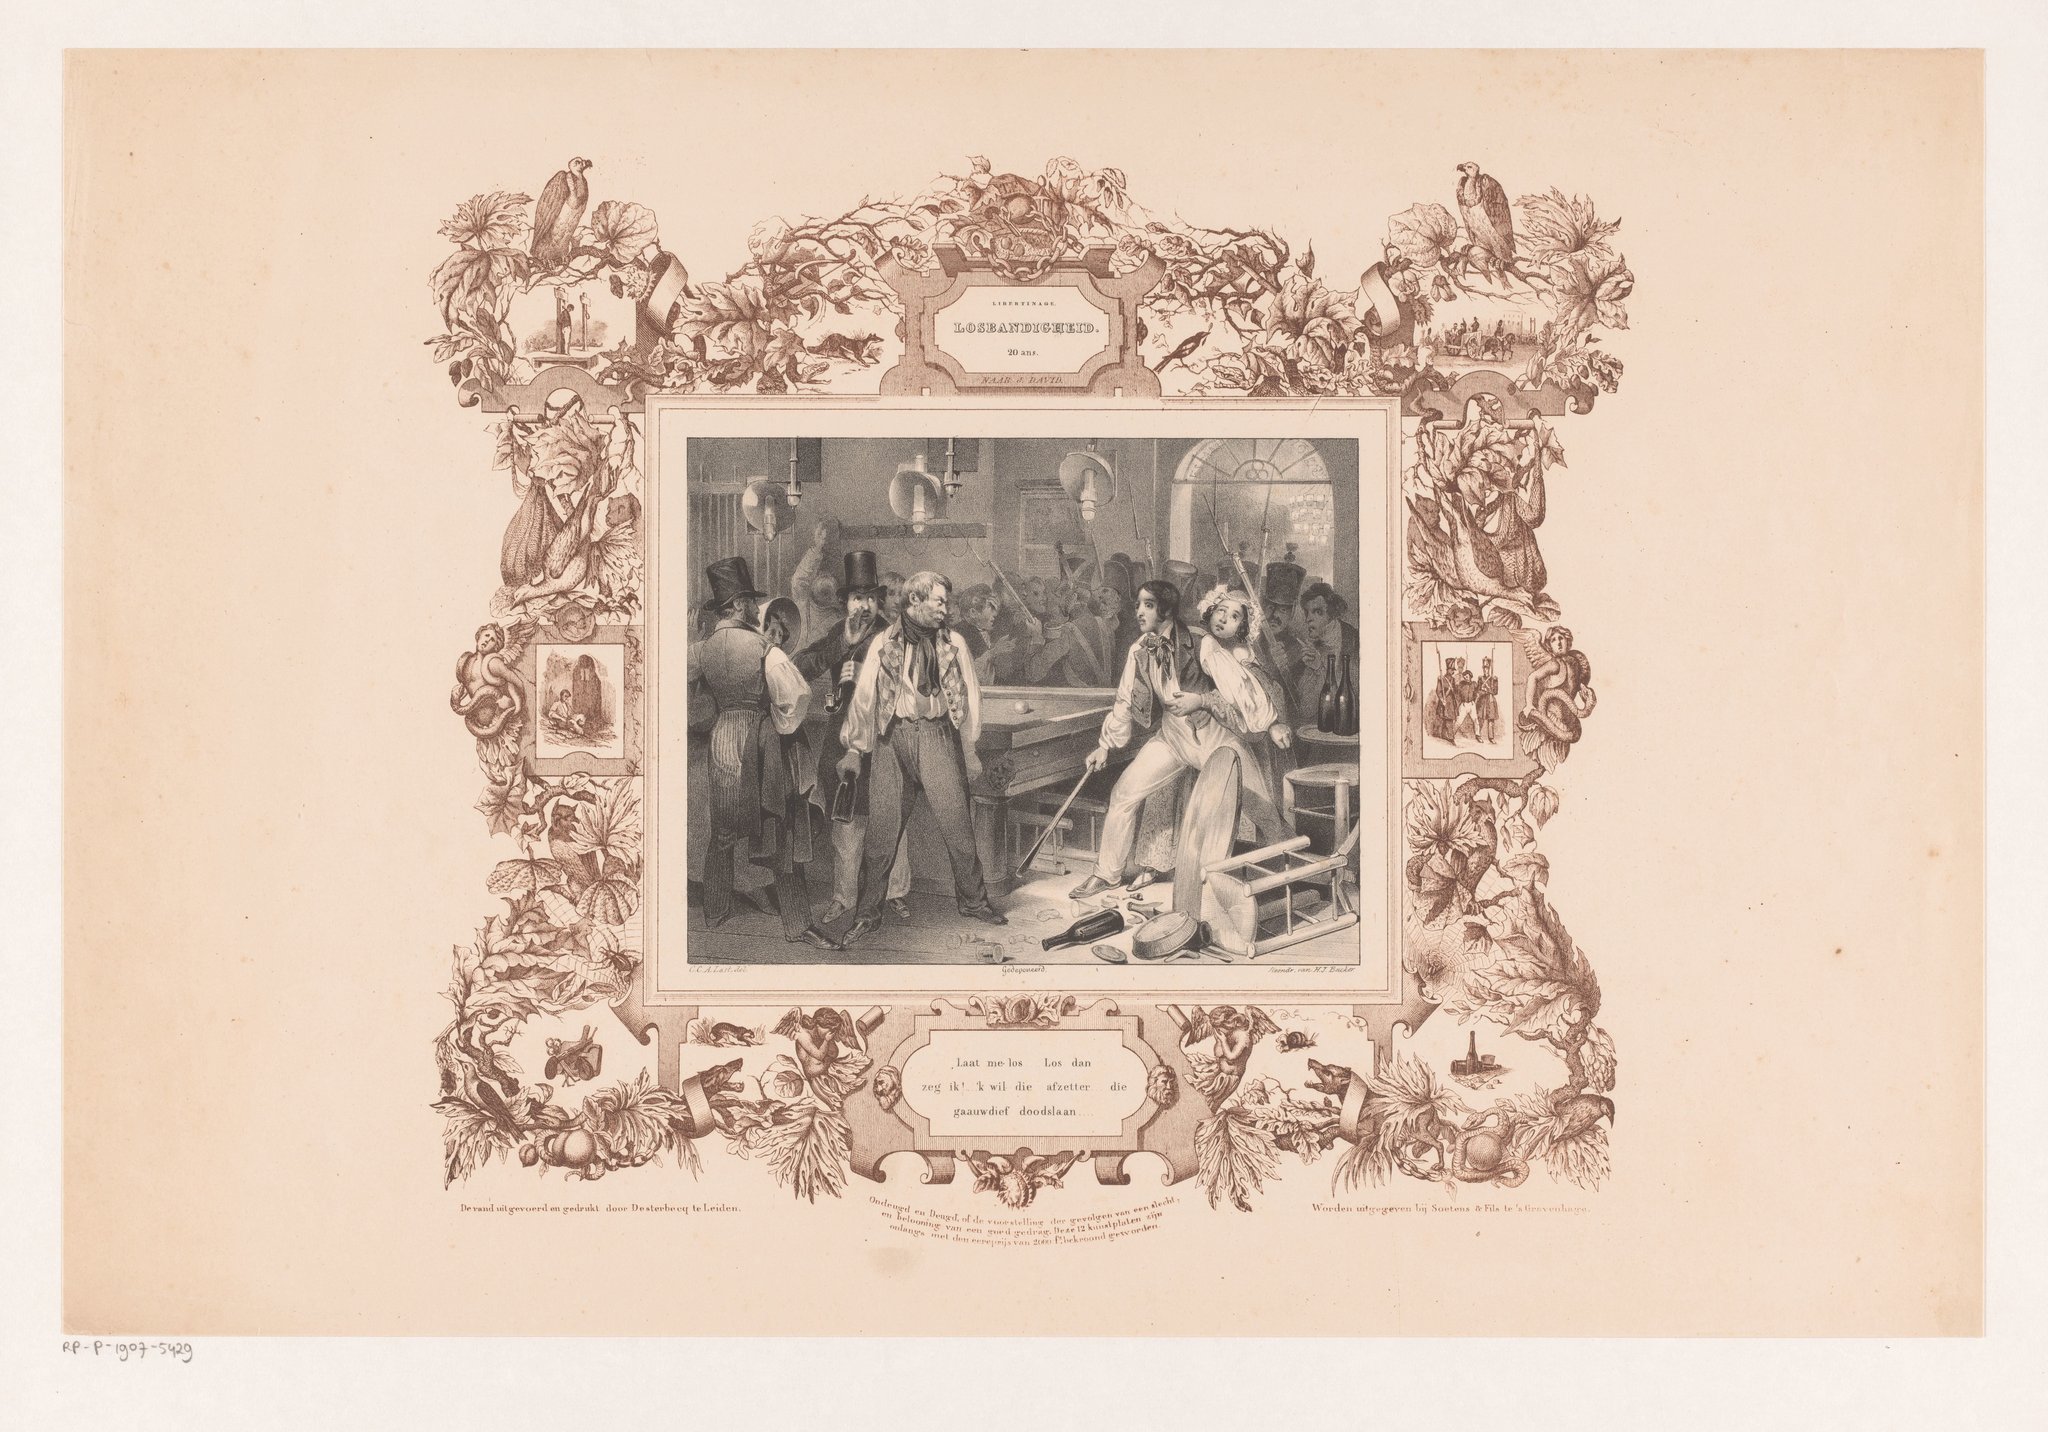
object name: print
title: Libertinage / Losbandigheid / 20 ans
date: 1837-1840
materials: paper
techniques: lithograph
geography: the hague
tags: arrest (of criminal), drunken brawl (usually peasants fighting in an inn)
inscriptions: collector's mark: Lugt 2228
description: Een jongeman naast een pooltafel wordt tegengehouden door een meisje. Voor hem staat een man klaar om hem te slaan met een fles. Achter hen komen politieagenten binnen. In de rand symbolen die verwijzen naar ondeugd zoals een arrestatie, een gevangene en flessen drank.